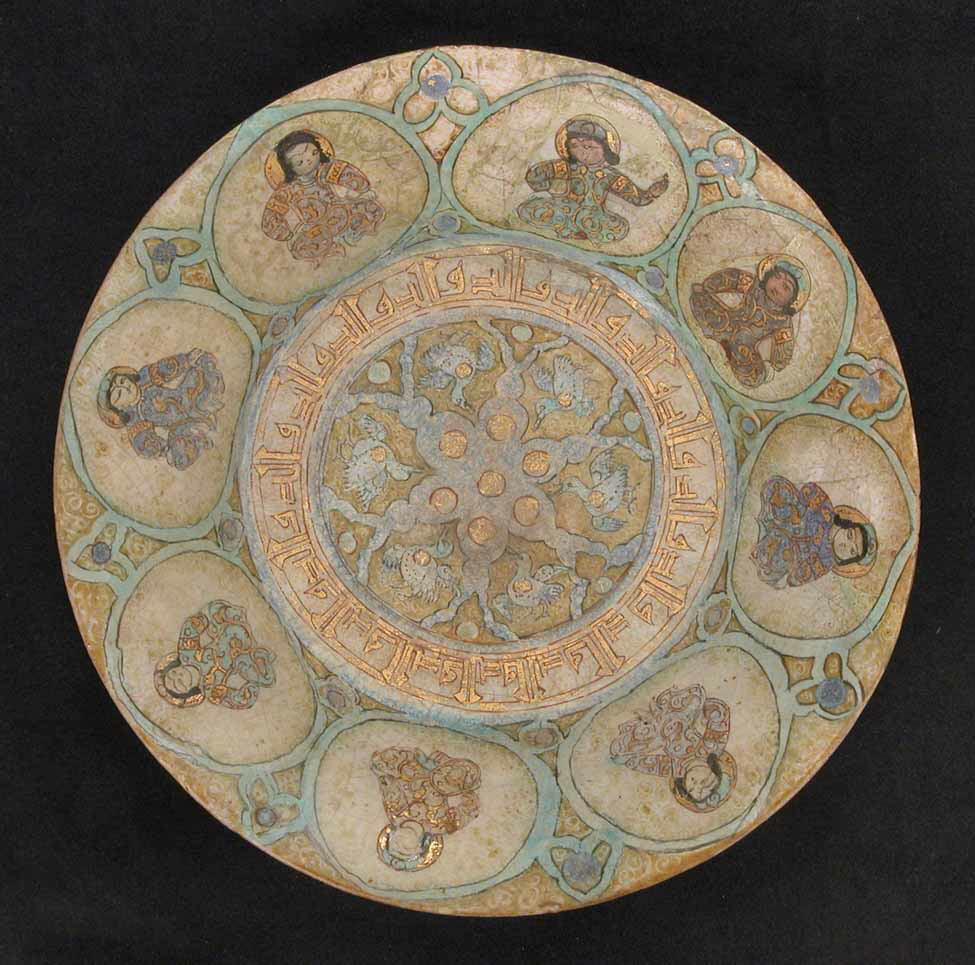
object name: bowl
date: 1101-1200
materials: stonepaste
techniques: overglaze, painting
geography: iran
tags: human figures